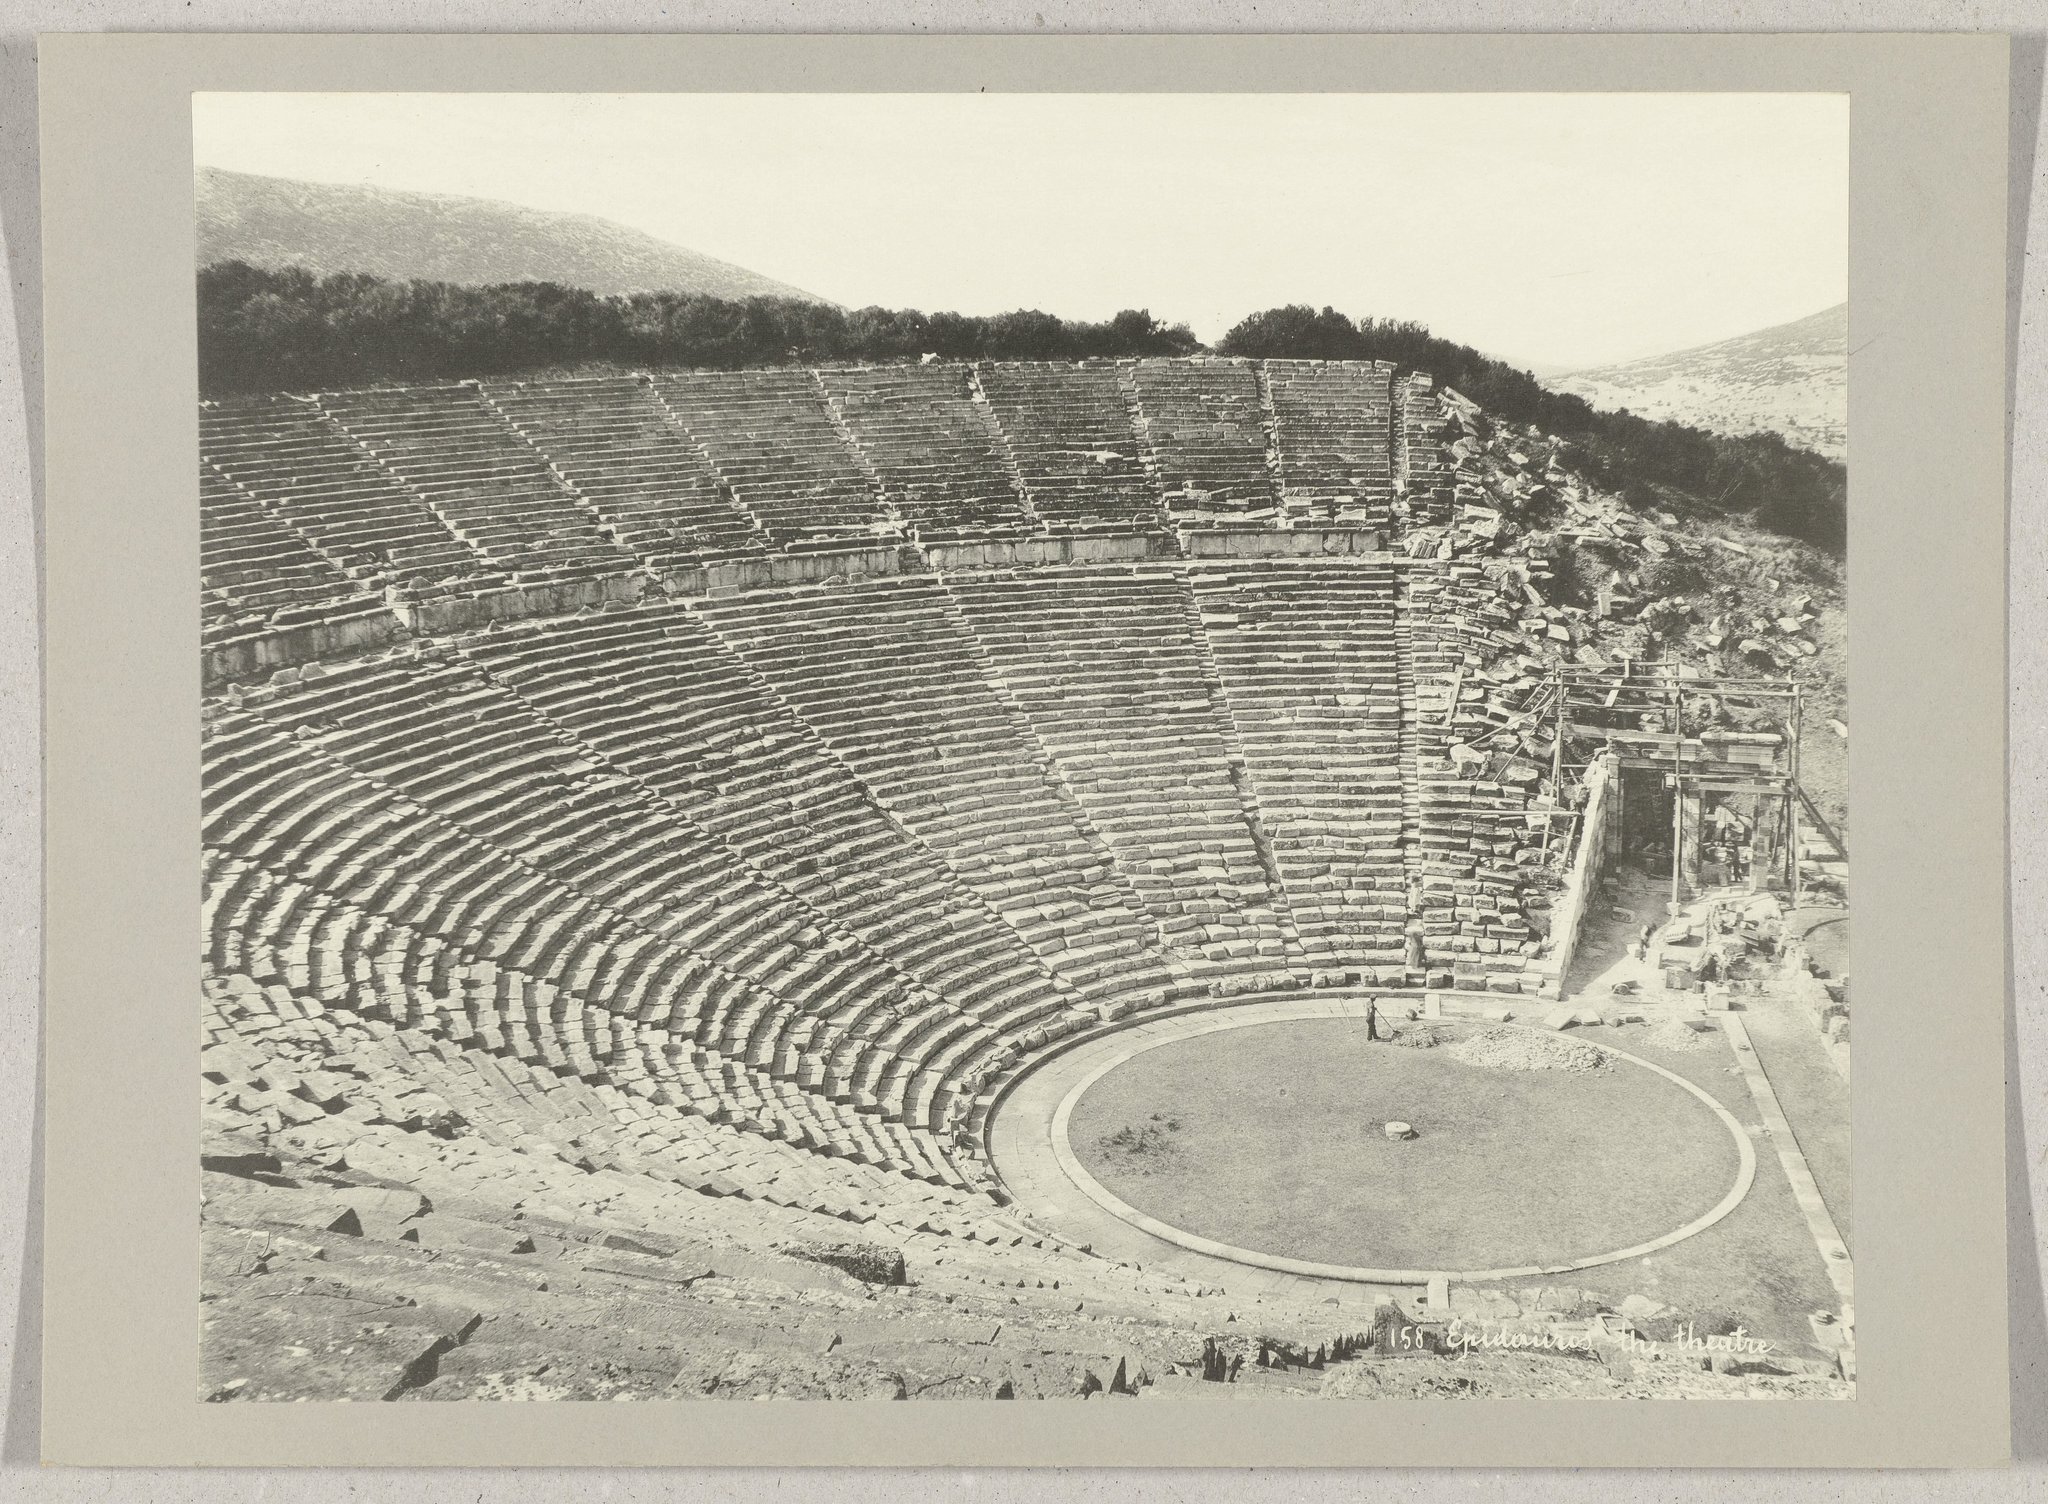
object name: photograph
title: Theater bij Epidauros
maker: Anonymous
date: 1895-1915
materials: cardboard, paper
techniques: photograph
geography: argos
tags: árgos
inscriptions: number: ‘8.’